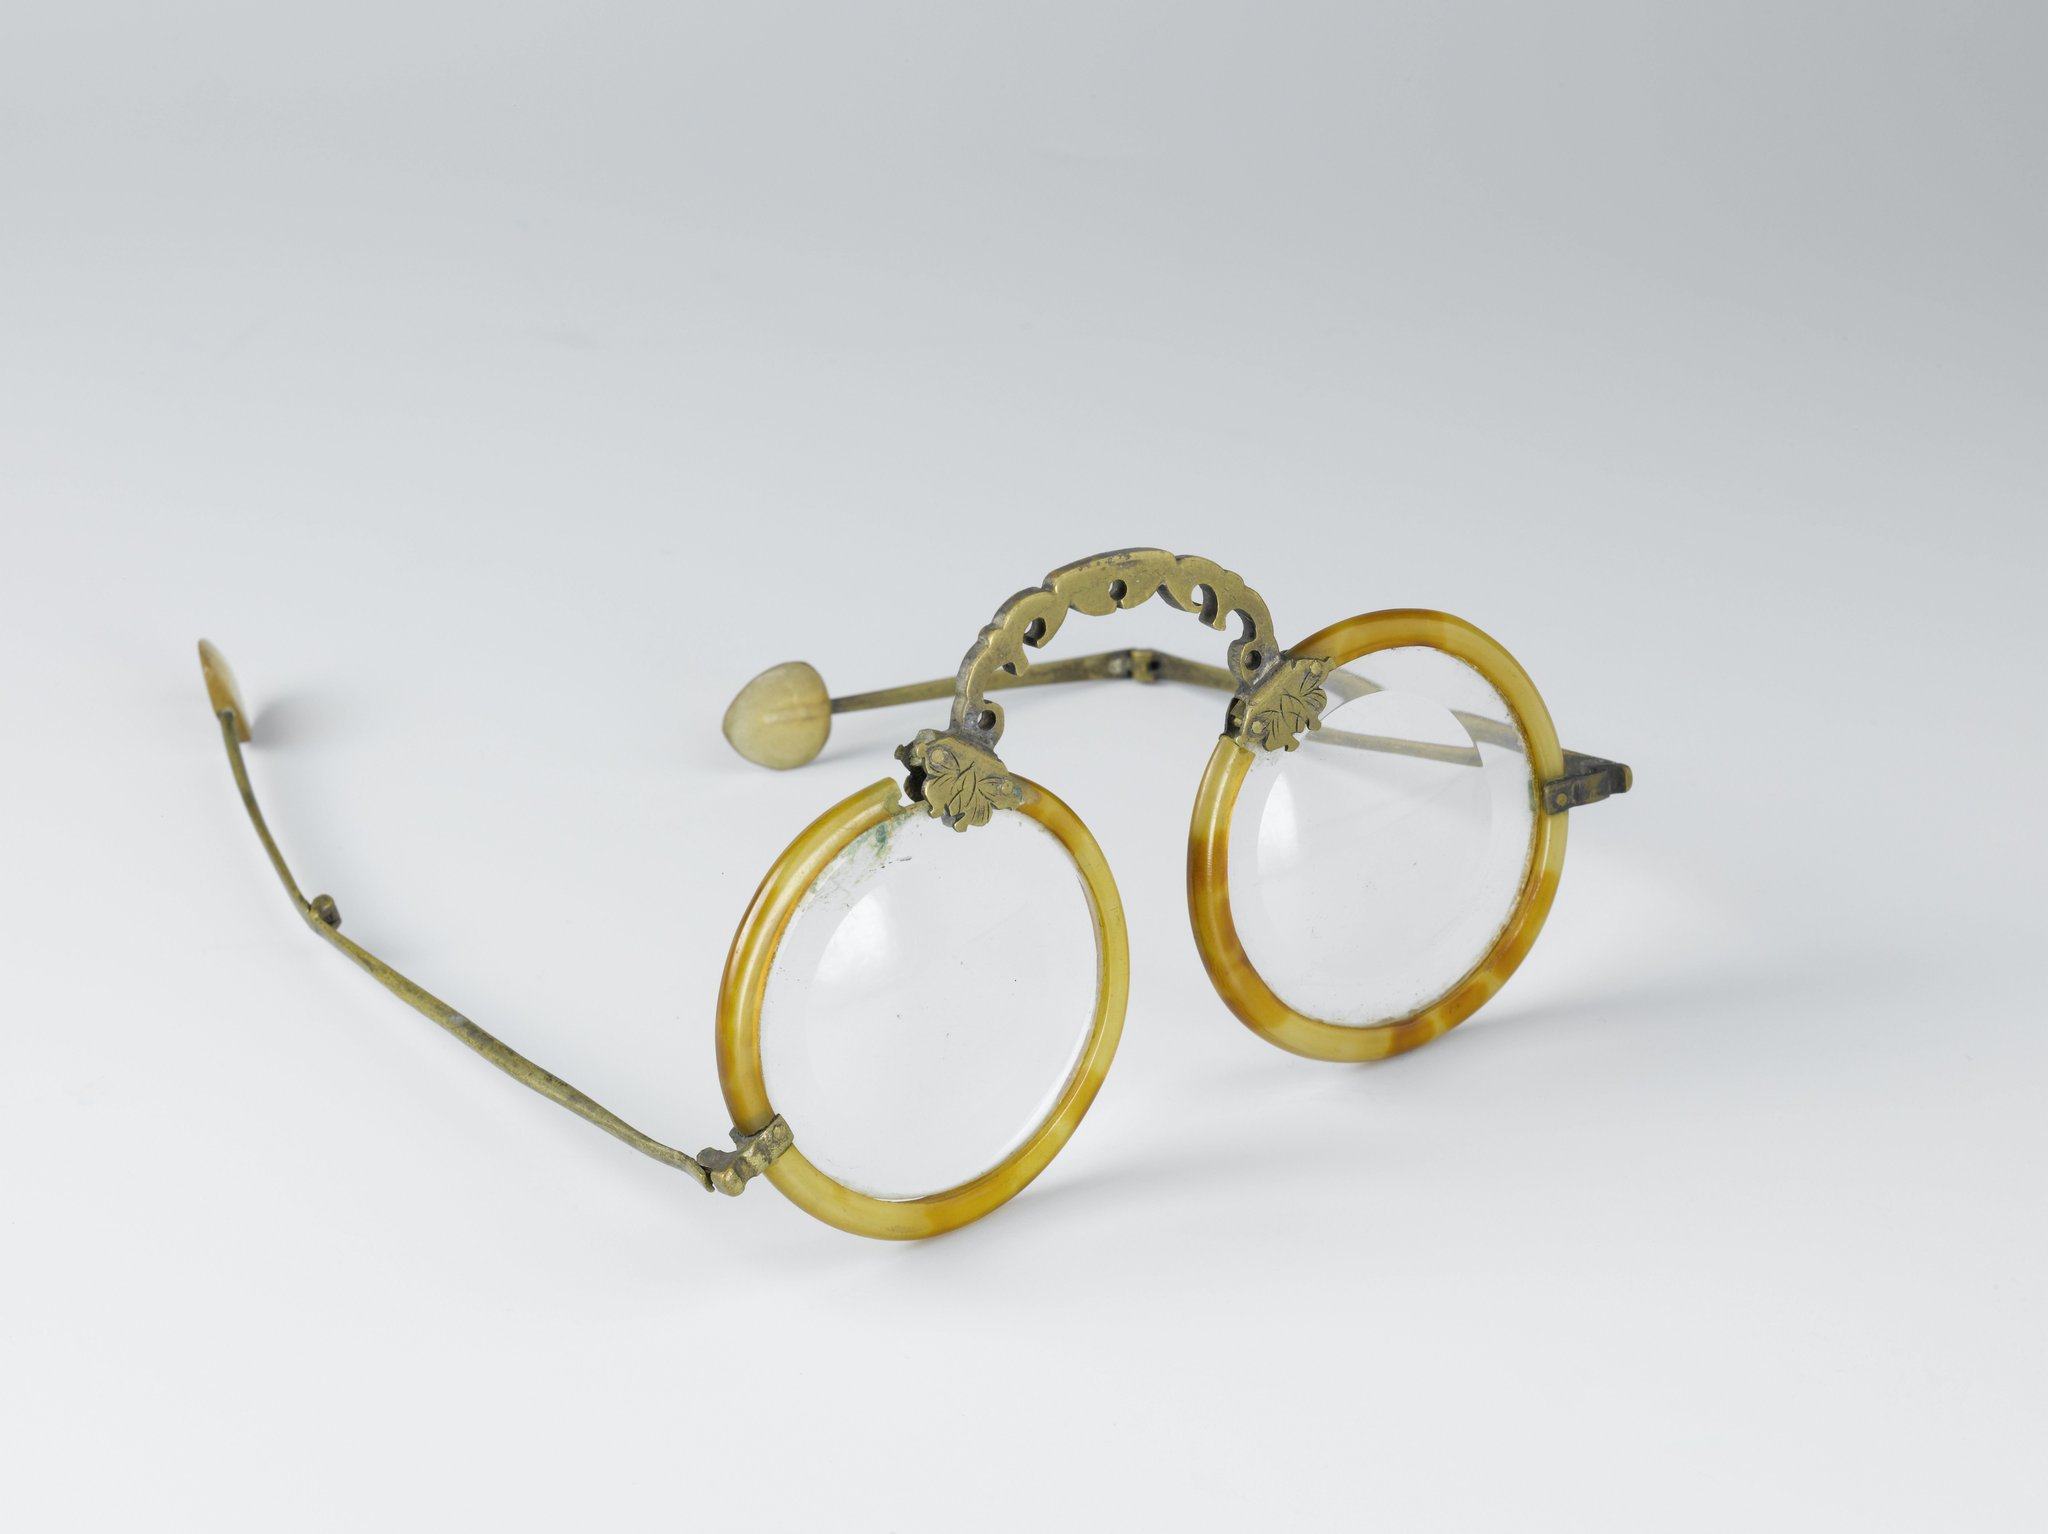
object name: spectacle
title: Bril met montuur van koper en blond schildpad of hoorn en ronde geslepen glazen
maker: Anonymous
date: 1780-1800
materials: copper, glass, shell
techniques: cutting, forging, grinding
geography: china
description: Bril met montuur van koper en blond schildpad en ronde geslepen glazen. Model: de hoge en brede brug is opgebouwd uit een aantal krullen en eindigt in een symmetrische vorm met twee schroeven op de schildpad rand. Het symmetrische uiteinde meteen ook als verbinding tussen en sluiting van de schildpad randen die aan de bovenkant open zijn. De benen staan uit vanaf de glazen en hebben halverwege een scharnier. Zij eindigen met ronde schijfjes van blond schildpad. Versiering: in de symmetrische vorm is een vlinder-achtige voorstelling gegraveerd. De glazen zijn rondom voorzien van een geslepen rand.